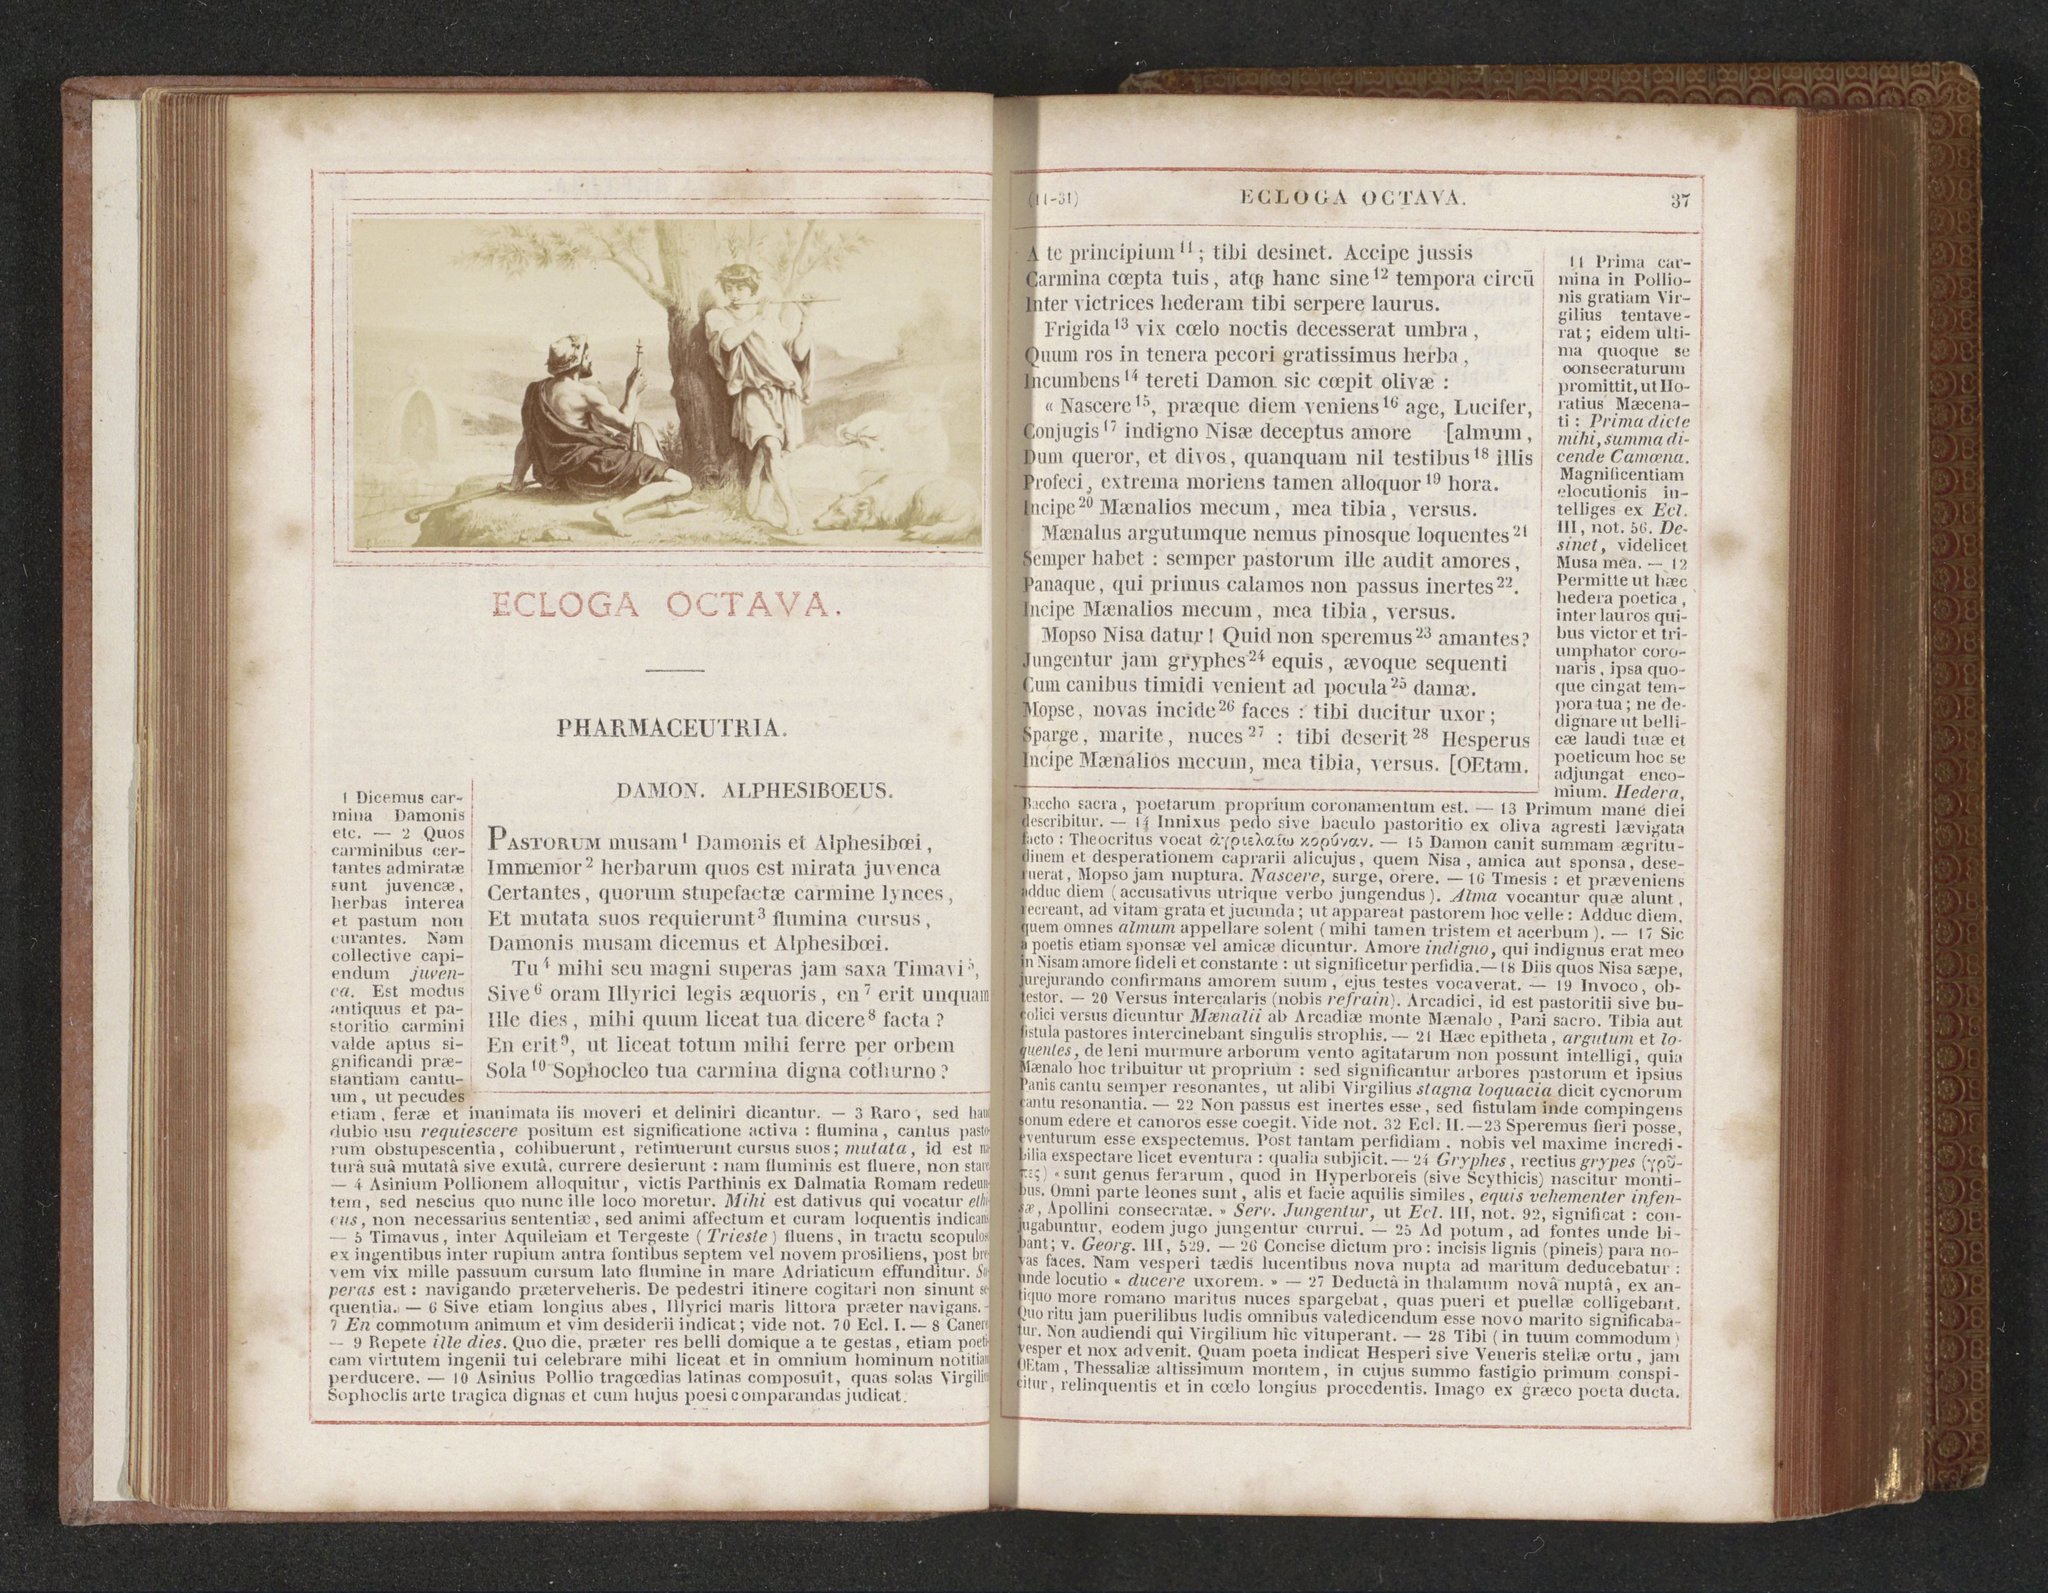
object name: photograph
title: Fotoreproductie van een schilderij, voorstellende Damon en Alphesiboeus met fluiten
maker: Anonymous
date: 1850-1858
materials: photographic support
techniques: albumen print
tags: herding, herdsman, herdswoman, shepherd, shepherdess, cowherd, etc., pastorals, arcadian scenes, flute, aulos, tibia